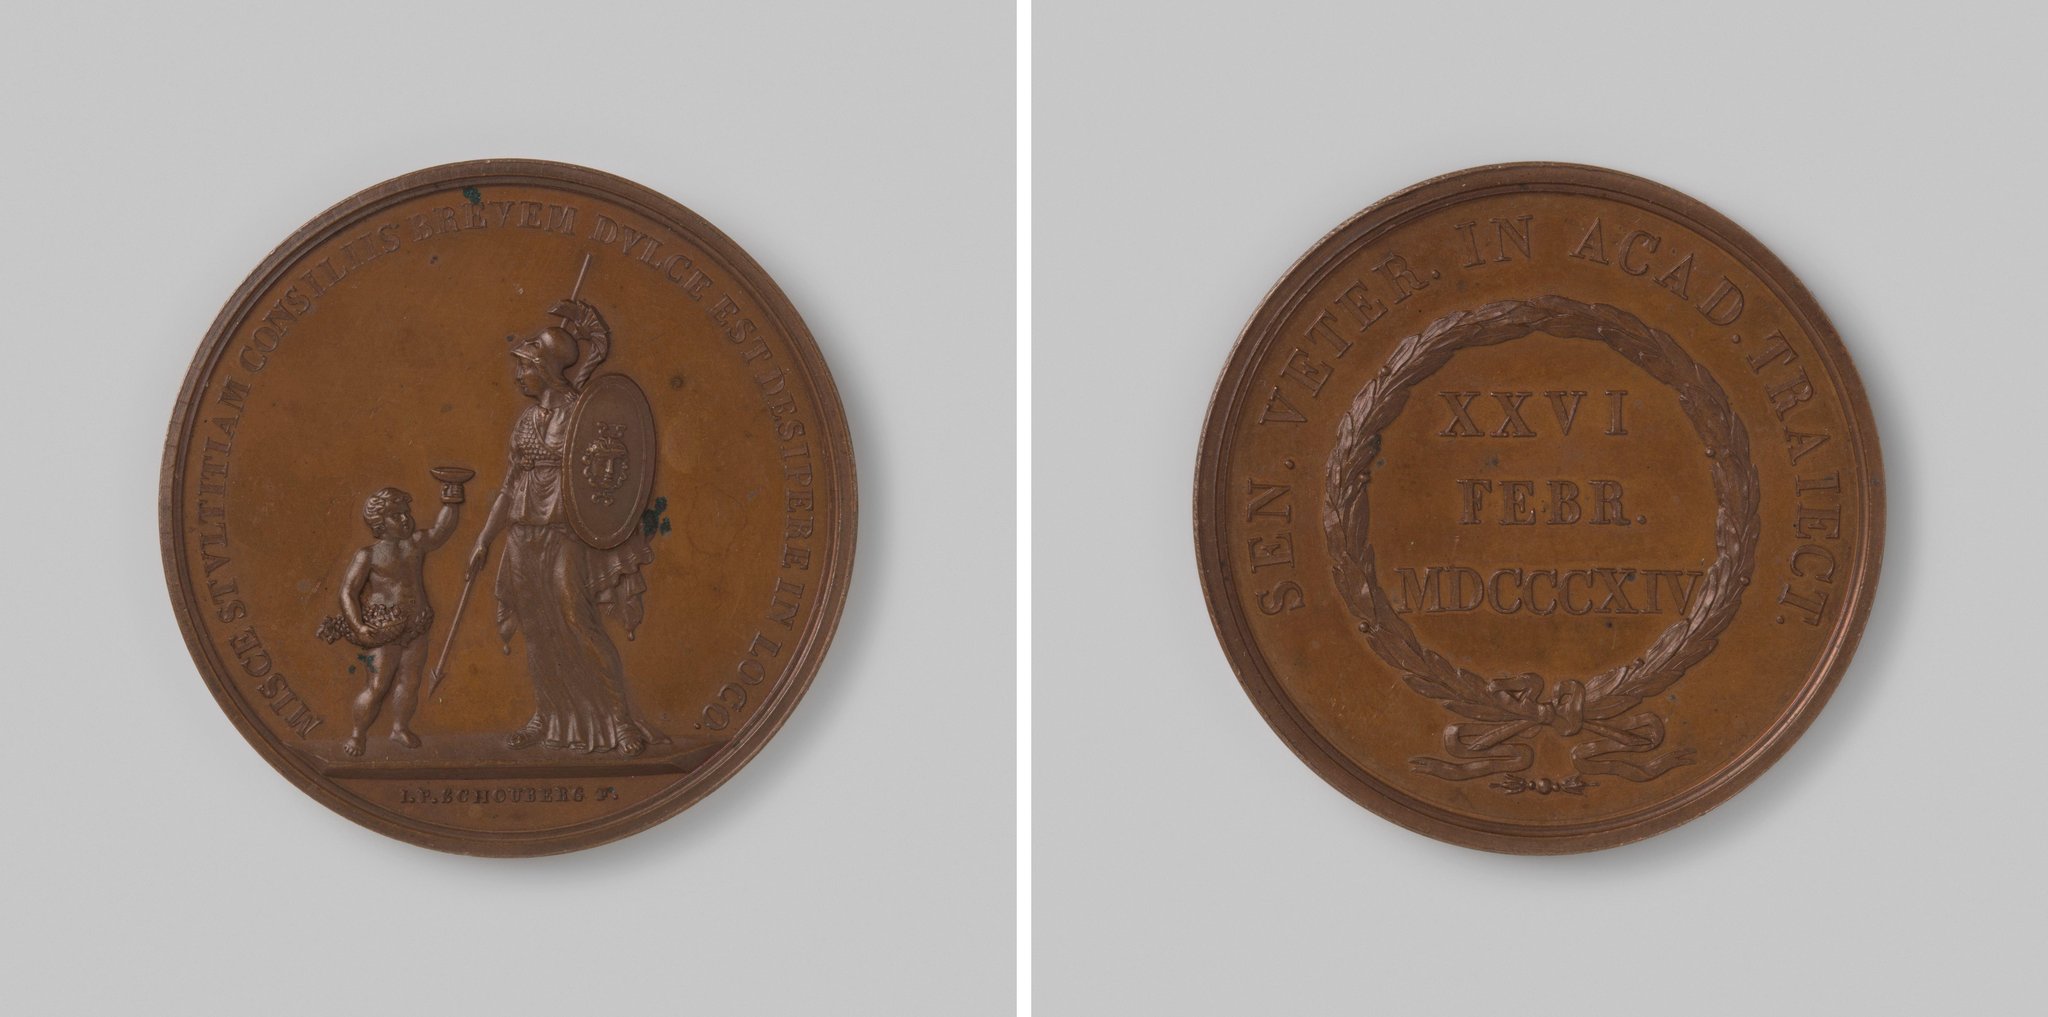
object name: history medal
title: Senatus Veteranorum te Utrecht 1814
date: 1814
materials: copper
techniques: striking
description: Koperen penning, op de voorzijde Minerva die een wijn krijgt aangeboden van een knaapje met druivenmand, met omschrift, op de keerzijde drie regels tekst tussen samengestrikte lauwertakken, met omschrift.